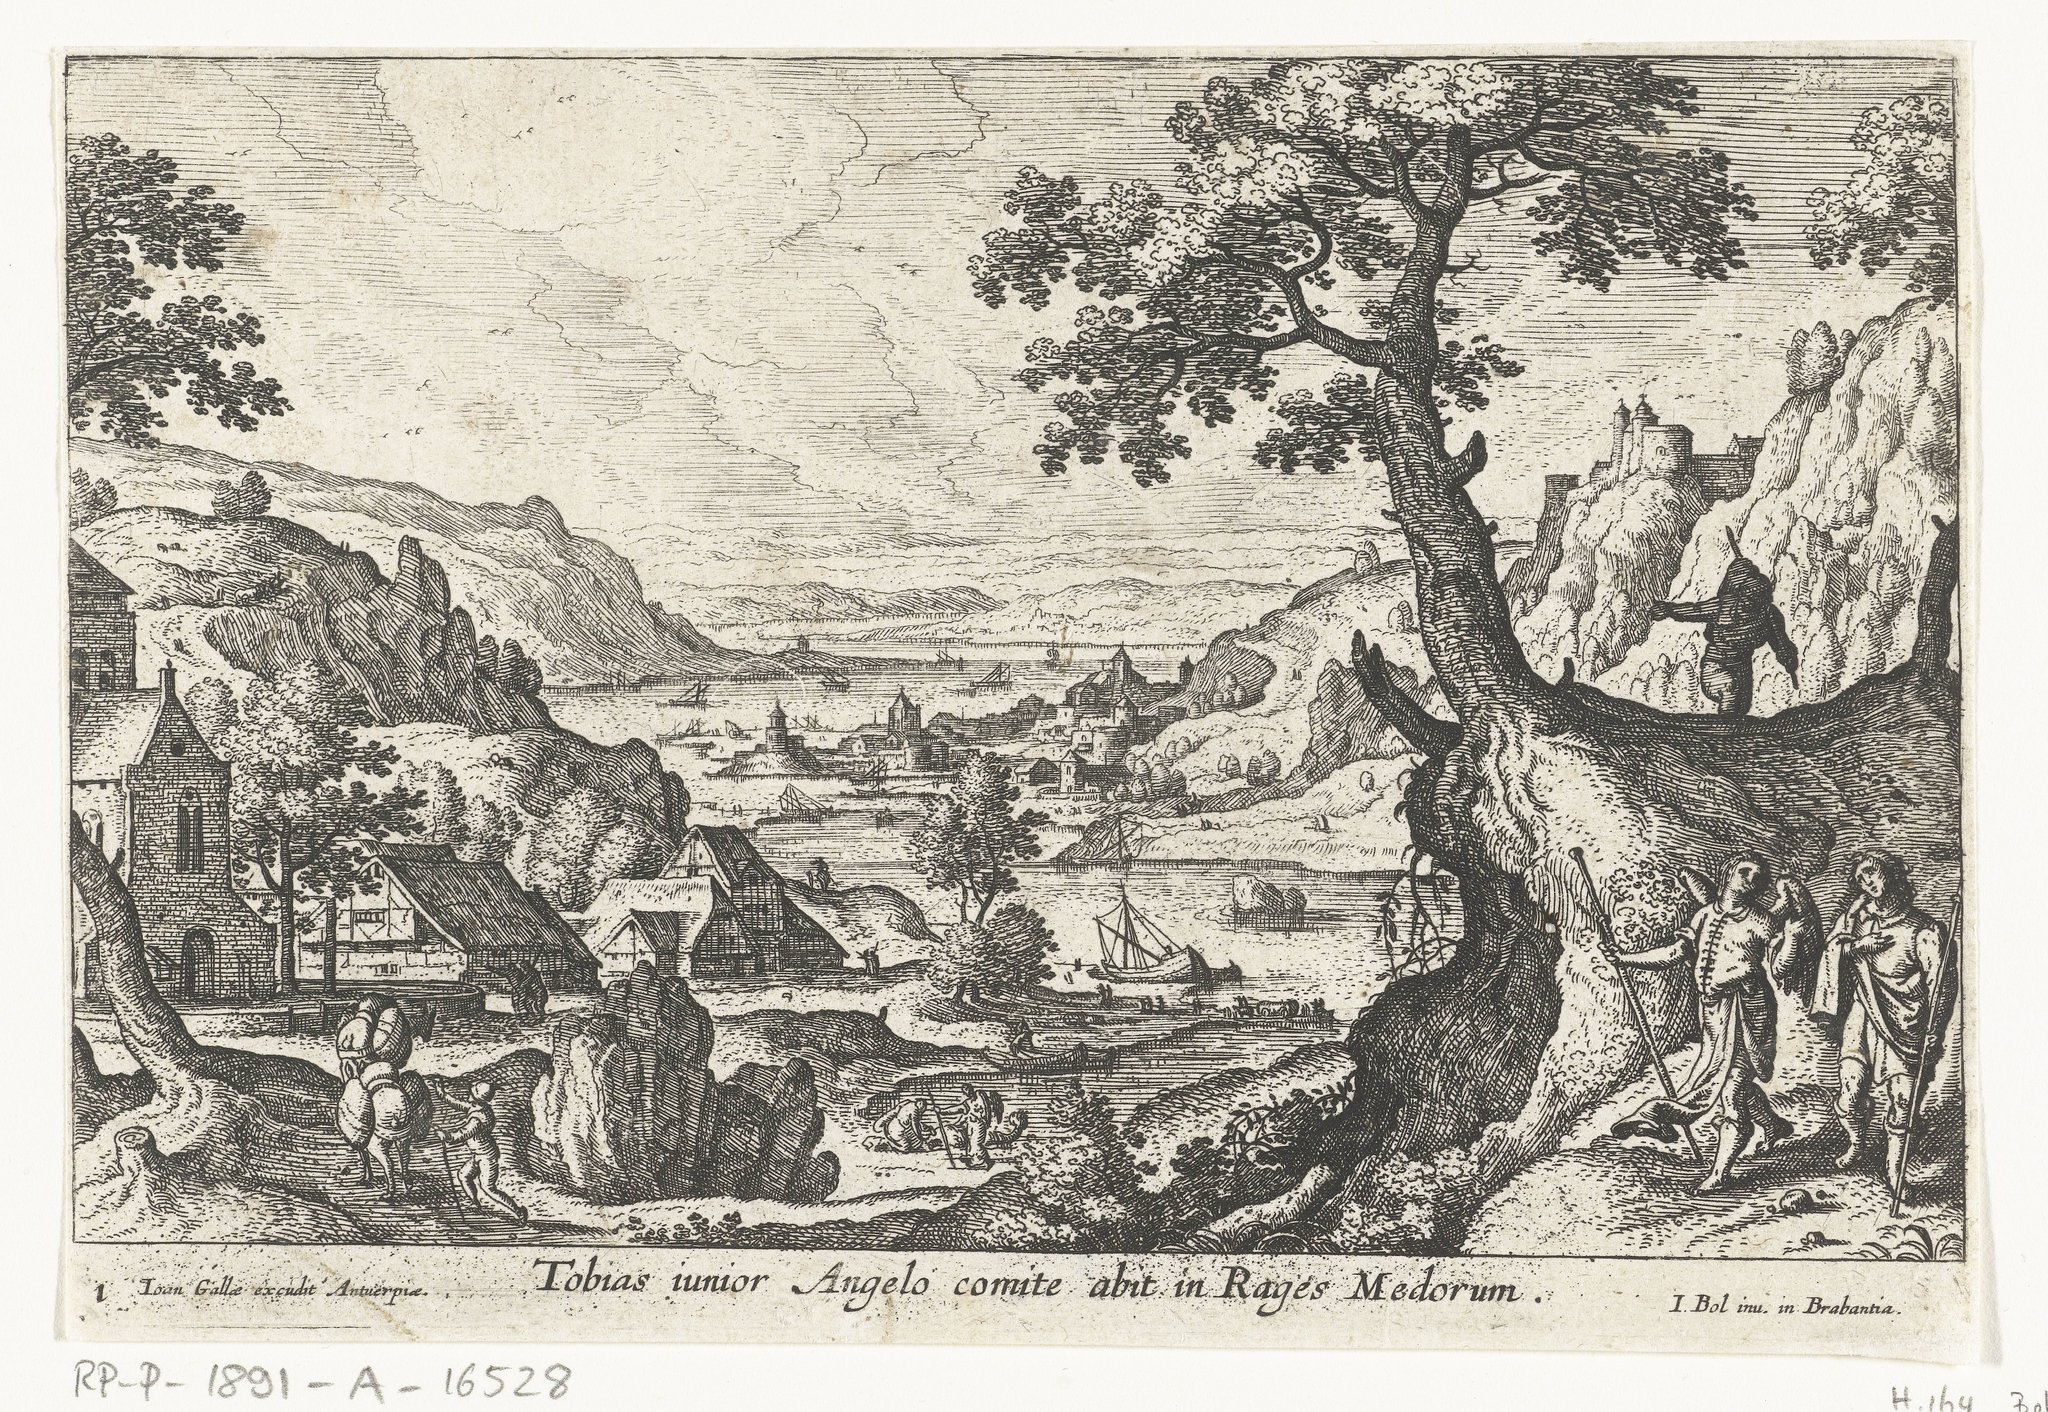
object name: print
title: Tobias iunior Angelo comite abit in Rages Medorum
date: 1620-1676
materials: paper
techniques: etching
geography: antwerp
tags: tobias and the angel raphael travelling, accompanied by tobias' dog, river, story of tobias: tobias and sarah (tobit 7-9)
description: Serie van 30 genummerde prenten. Volgorde blijft onduidelijk, omdat de nummering van verschillende staten (met of zonder onderschrift) afwijkt.